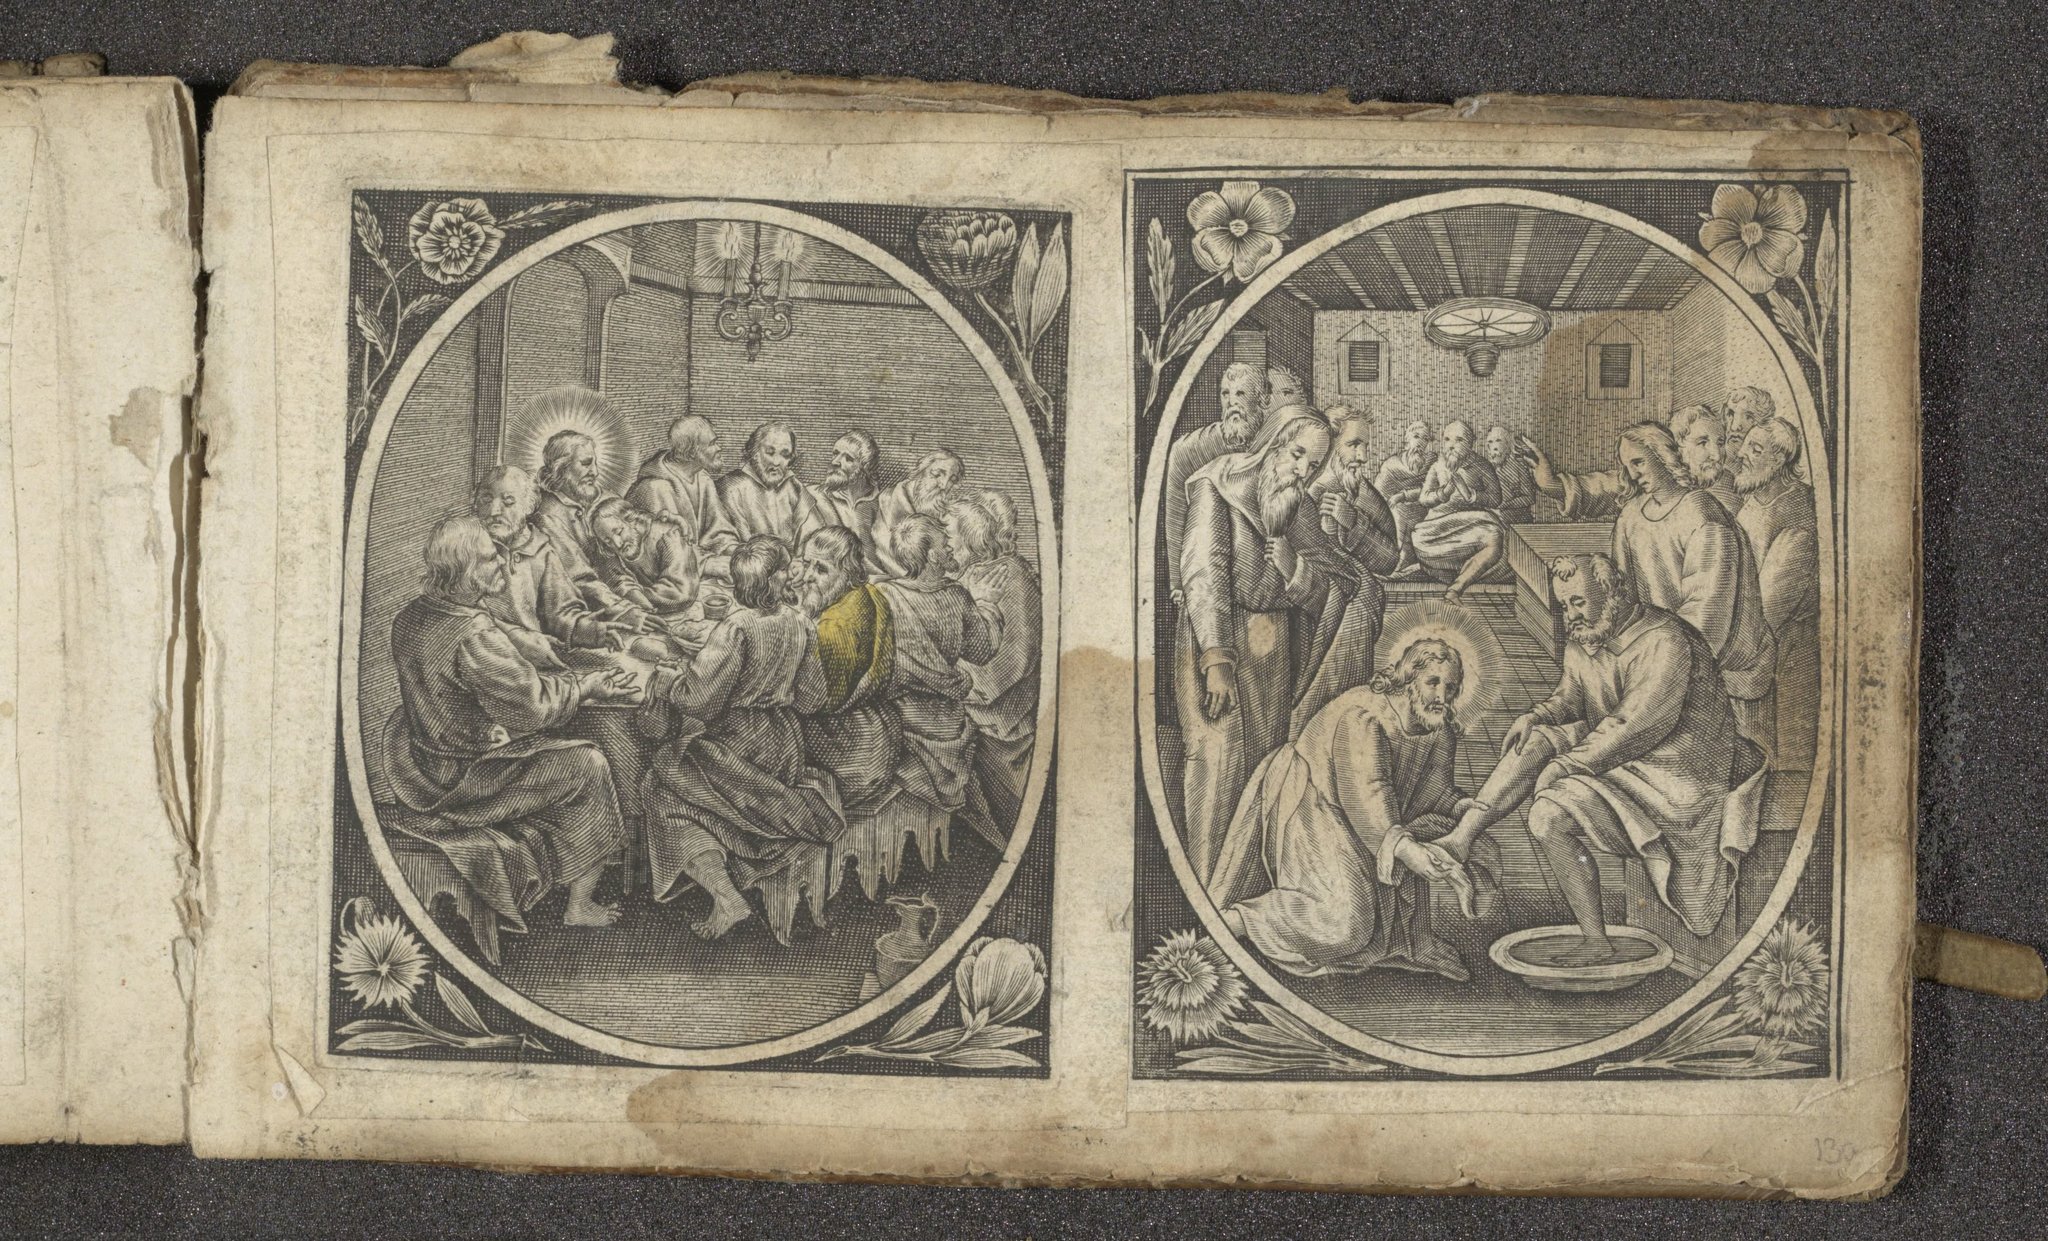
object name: album leaf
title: Voetwassing van Petrus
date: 1576-1650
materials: paper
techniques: engraving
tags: christ washes peter's feet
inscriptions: inscription: ‘87’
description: Christus zit geknield voor de apostel Petrus en wast zijn voeten. Ovaal binnen een rechthoekig kader, in elke hoek een bloem. De prent maakt deel uit van een album.